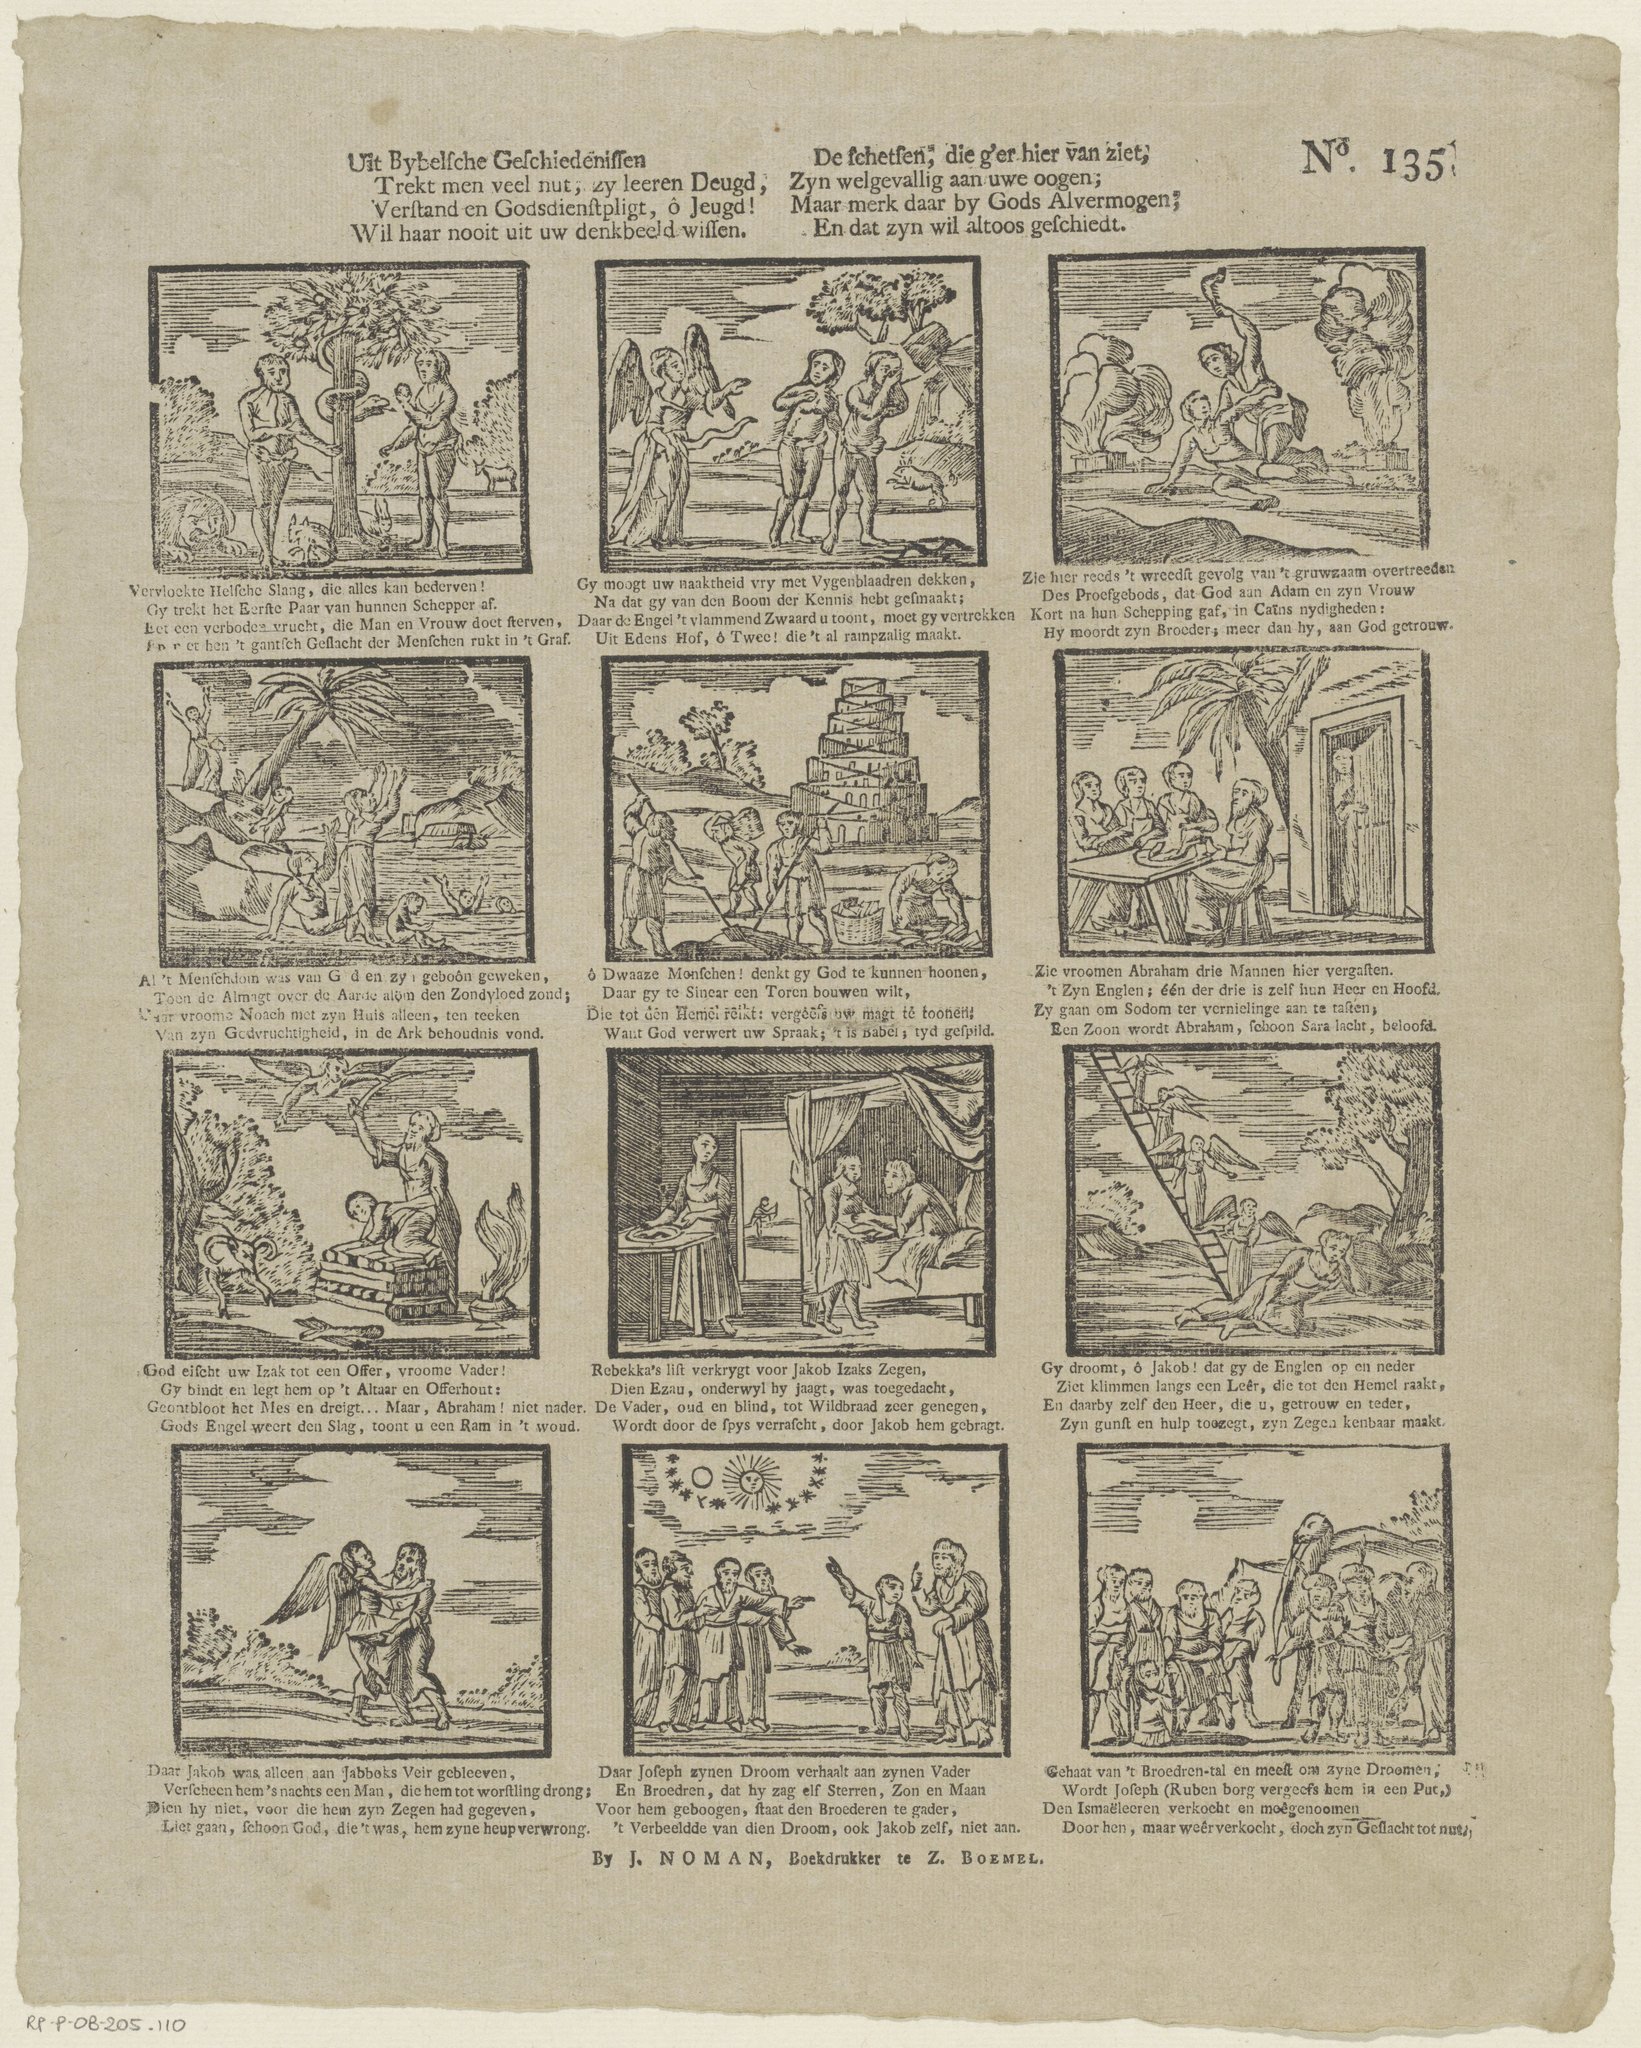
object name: print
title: Uit Bybelsche geschiedenissen / Trekt men veel nut; zy leeren deugd [(...)]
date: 1806-1830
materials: paper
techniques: letterpress printing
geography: netherlands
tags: expulsion of adam and eve from paradise (genesis 3:22-24), story of jacob, old testament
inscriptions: collector's mark: Lugt 2760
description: Blad met 12 voorstellingen van verhalen uit het Oude Testament, zoals de verdrijving van Adam en Eva uit het paradijs en de dood van Abel. Onder elke afbeelding een vierregelig vers. Genummerd rechtsboven: No. 135.